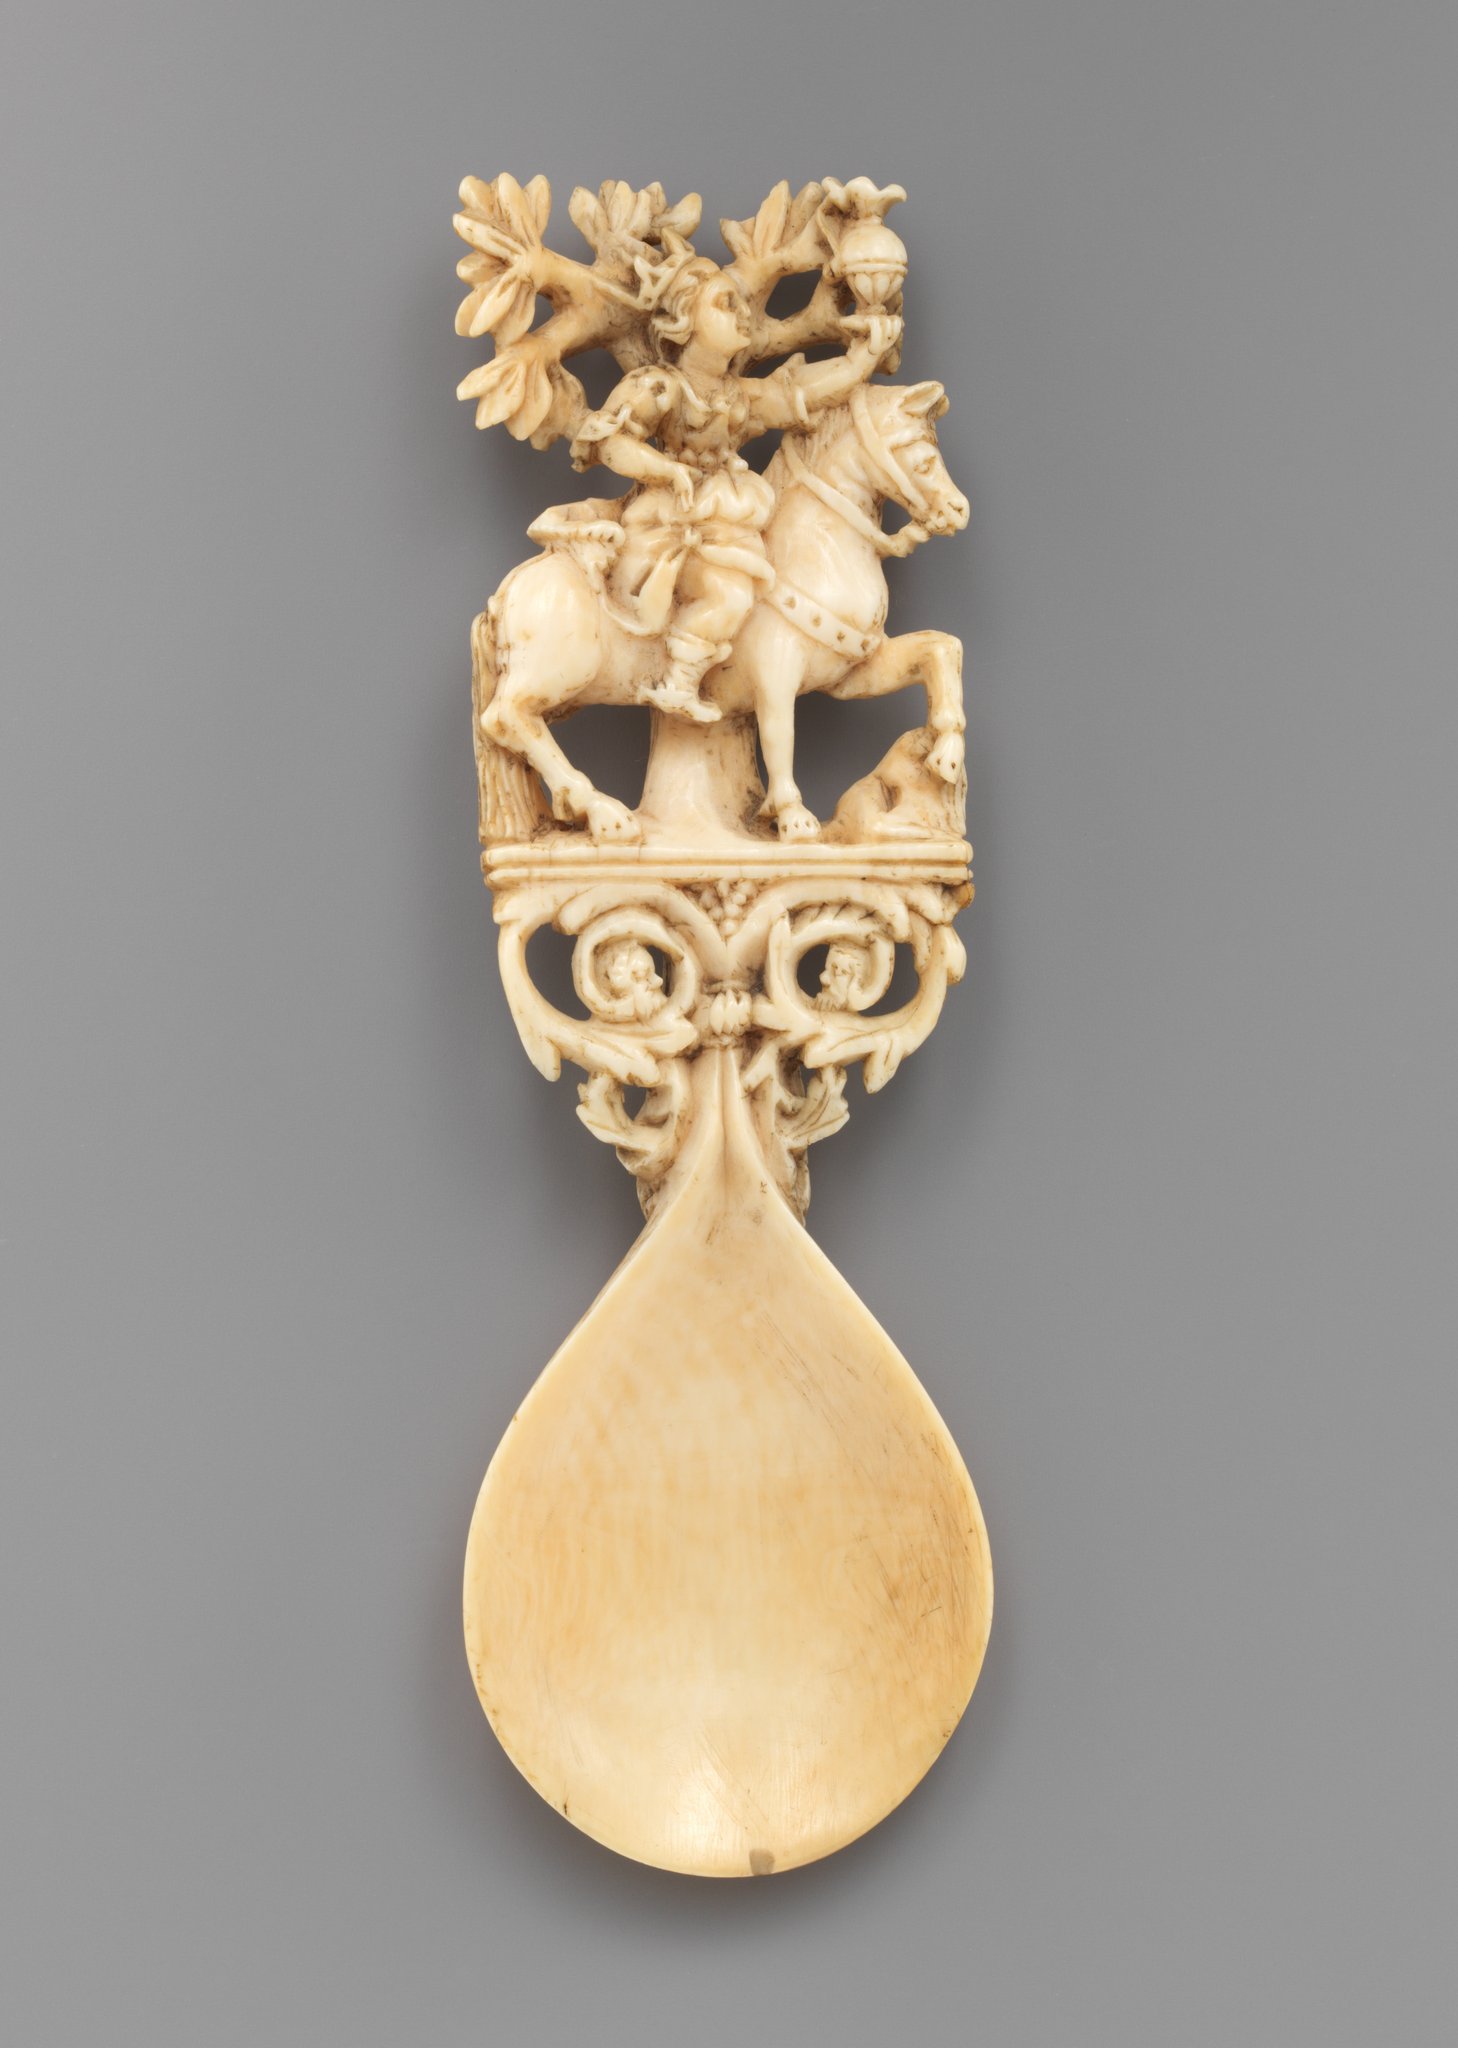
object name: spoon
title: Triumph of Temperance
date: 1501-1600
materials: ivory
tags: horses